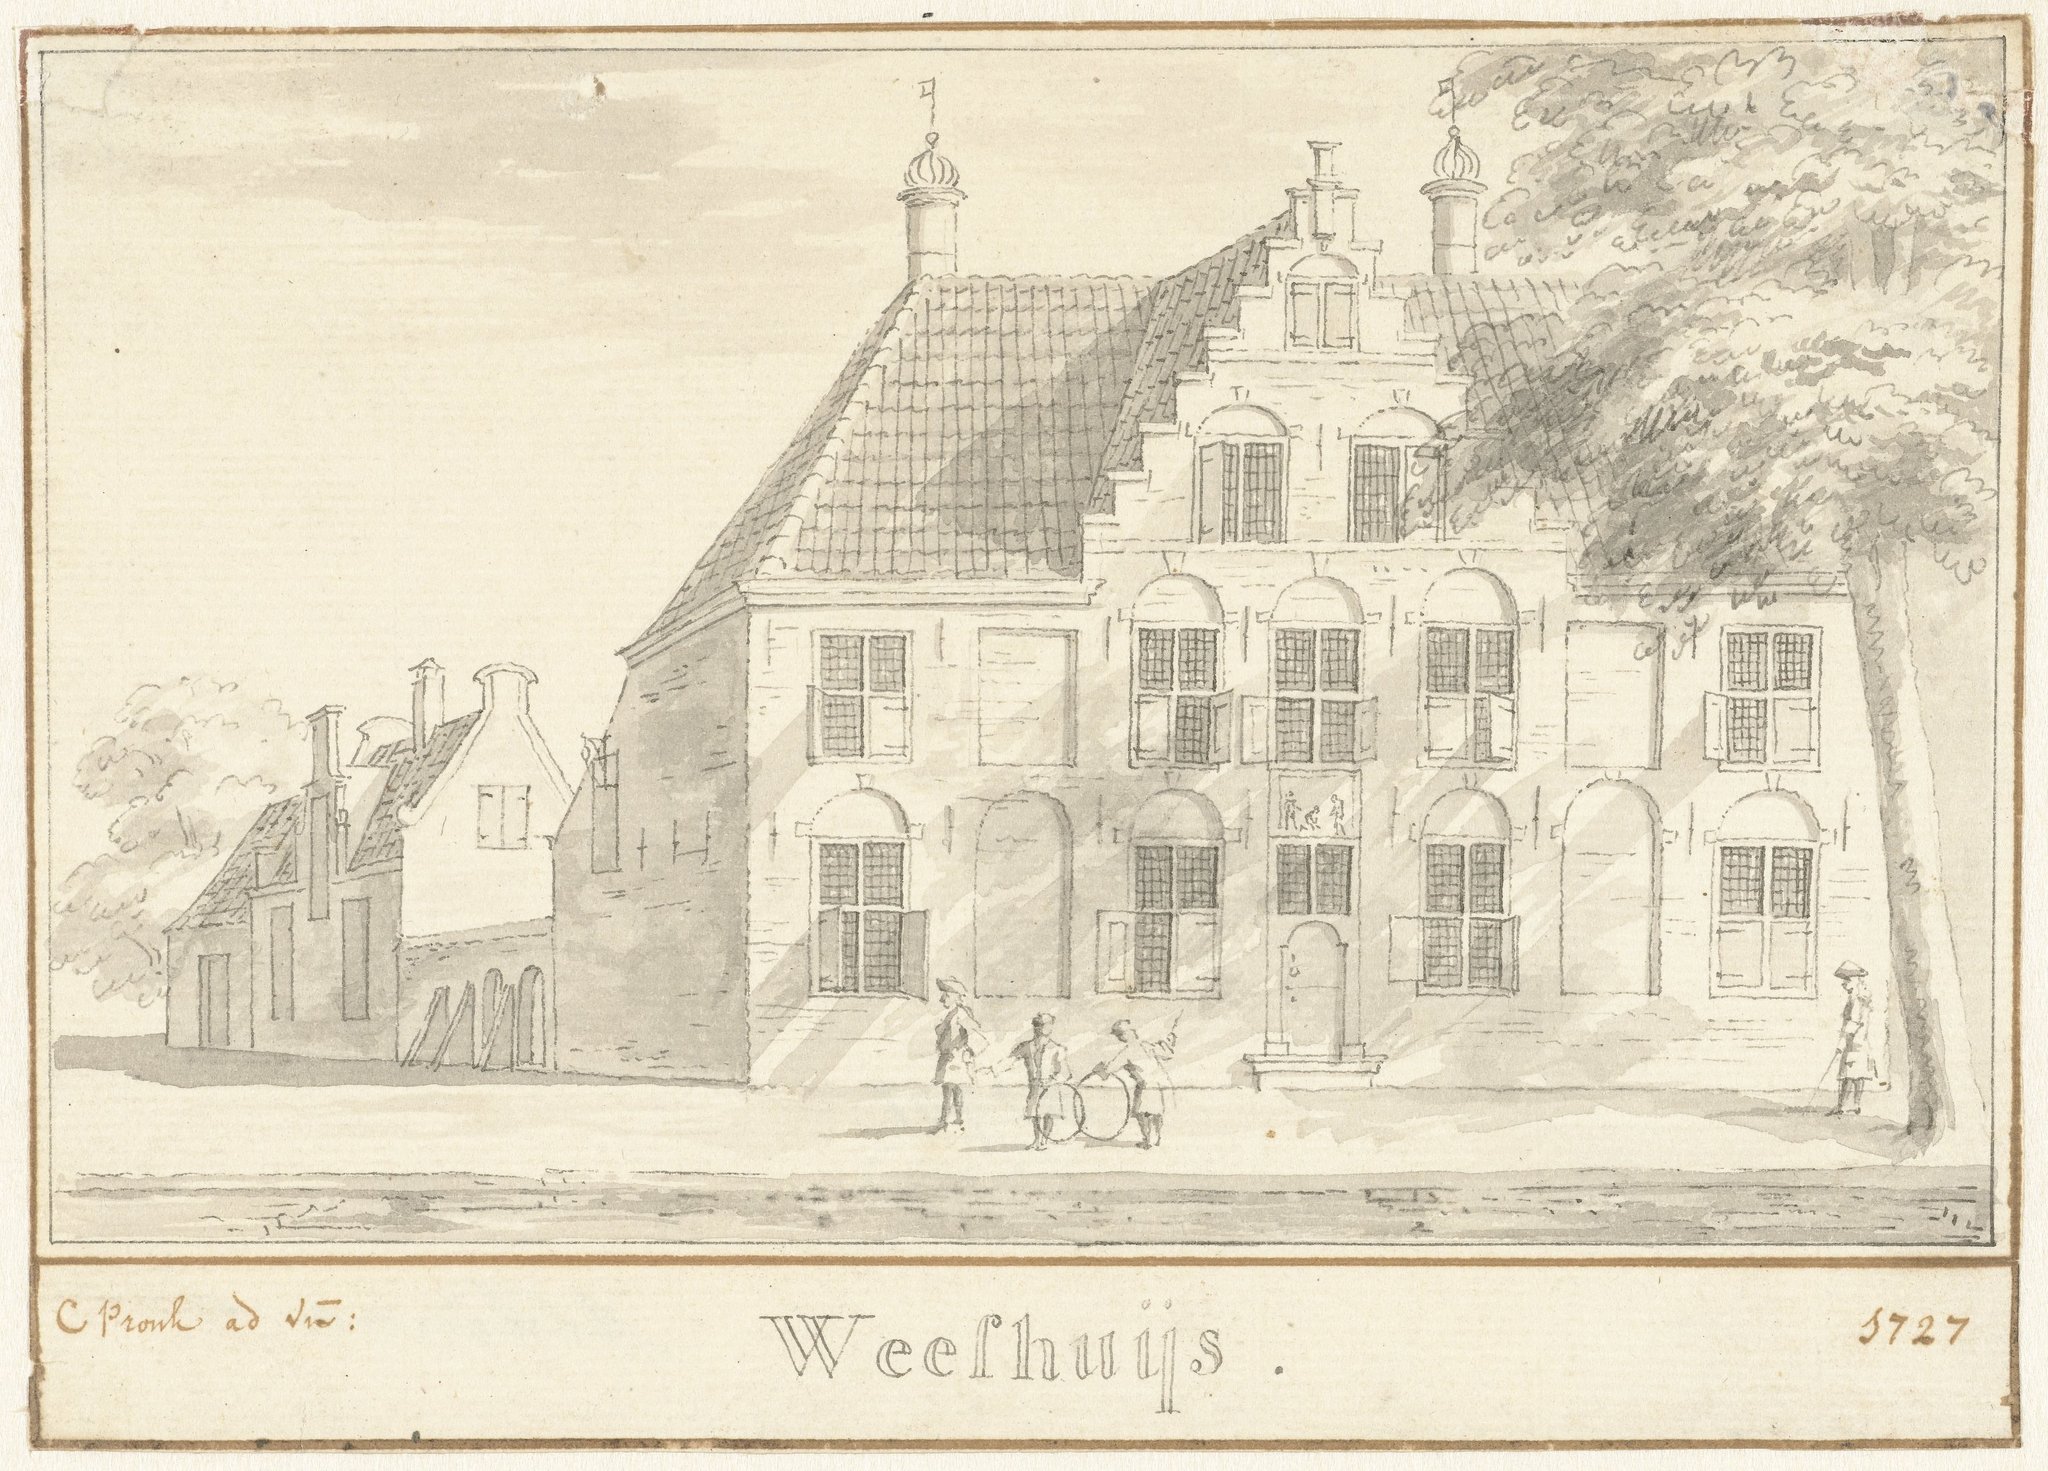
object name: drawing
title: Het weeshuis te Alkmaar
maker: cornelis pronk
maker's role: draughtsman, painter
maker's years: 1691-1759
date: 1727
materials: ink, paper, pencil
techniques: brush, pen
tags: orphanage